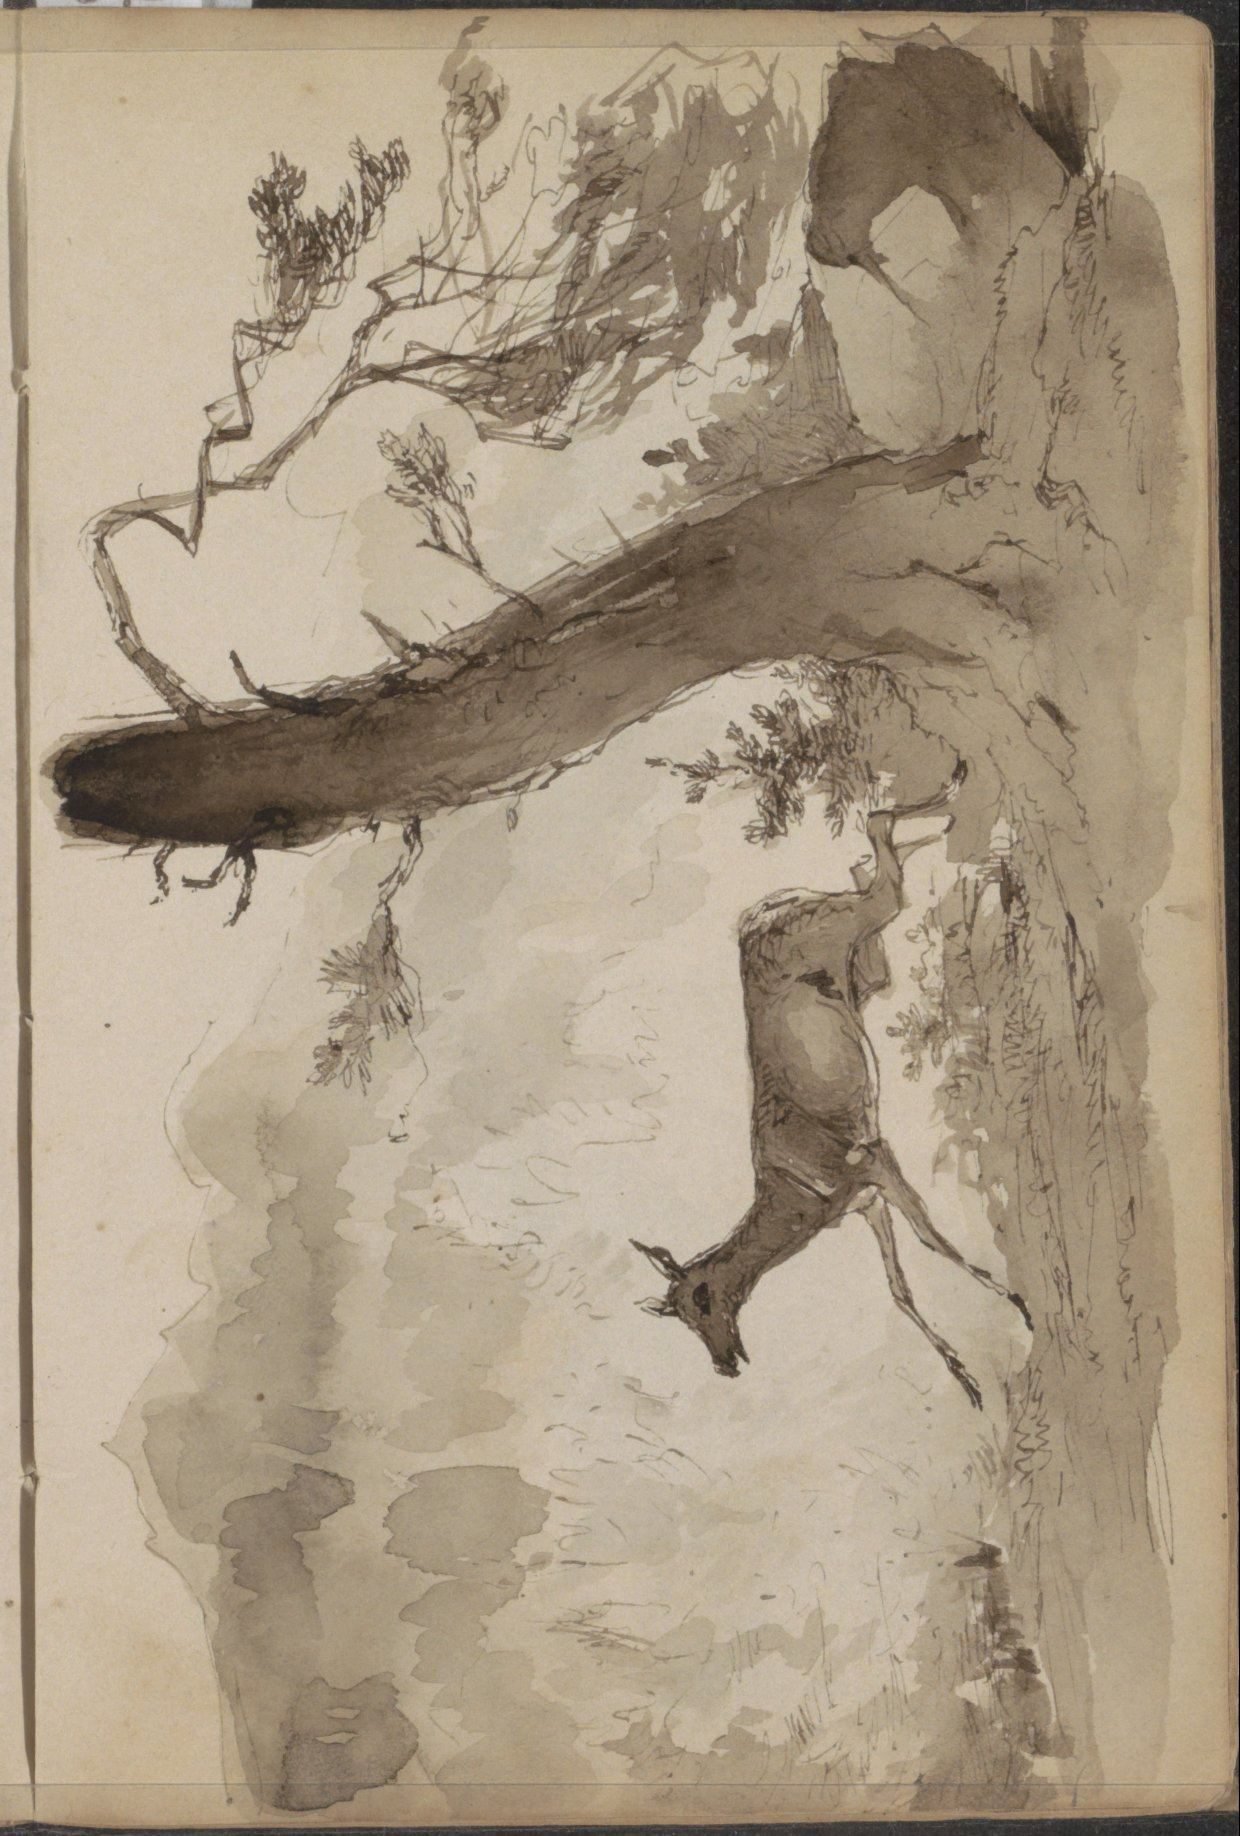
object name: sketchbook leaf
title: Berglandschap met een hert bij een boom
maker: johannes tavenraat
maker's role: draughtsman, painter, print maker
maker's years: 1809-1881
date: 1858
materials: ink, paper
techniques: brush, pen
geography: bohemia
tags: trees, hoofed animals: deer, mountains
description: Blad 18 recto uit een schetsboek met 44 bladen.